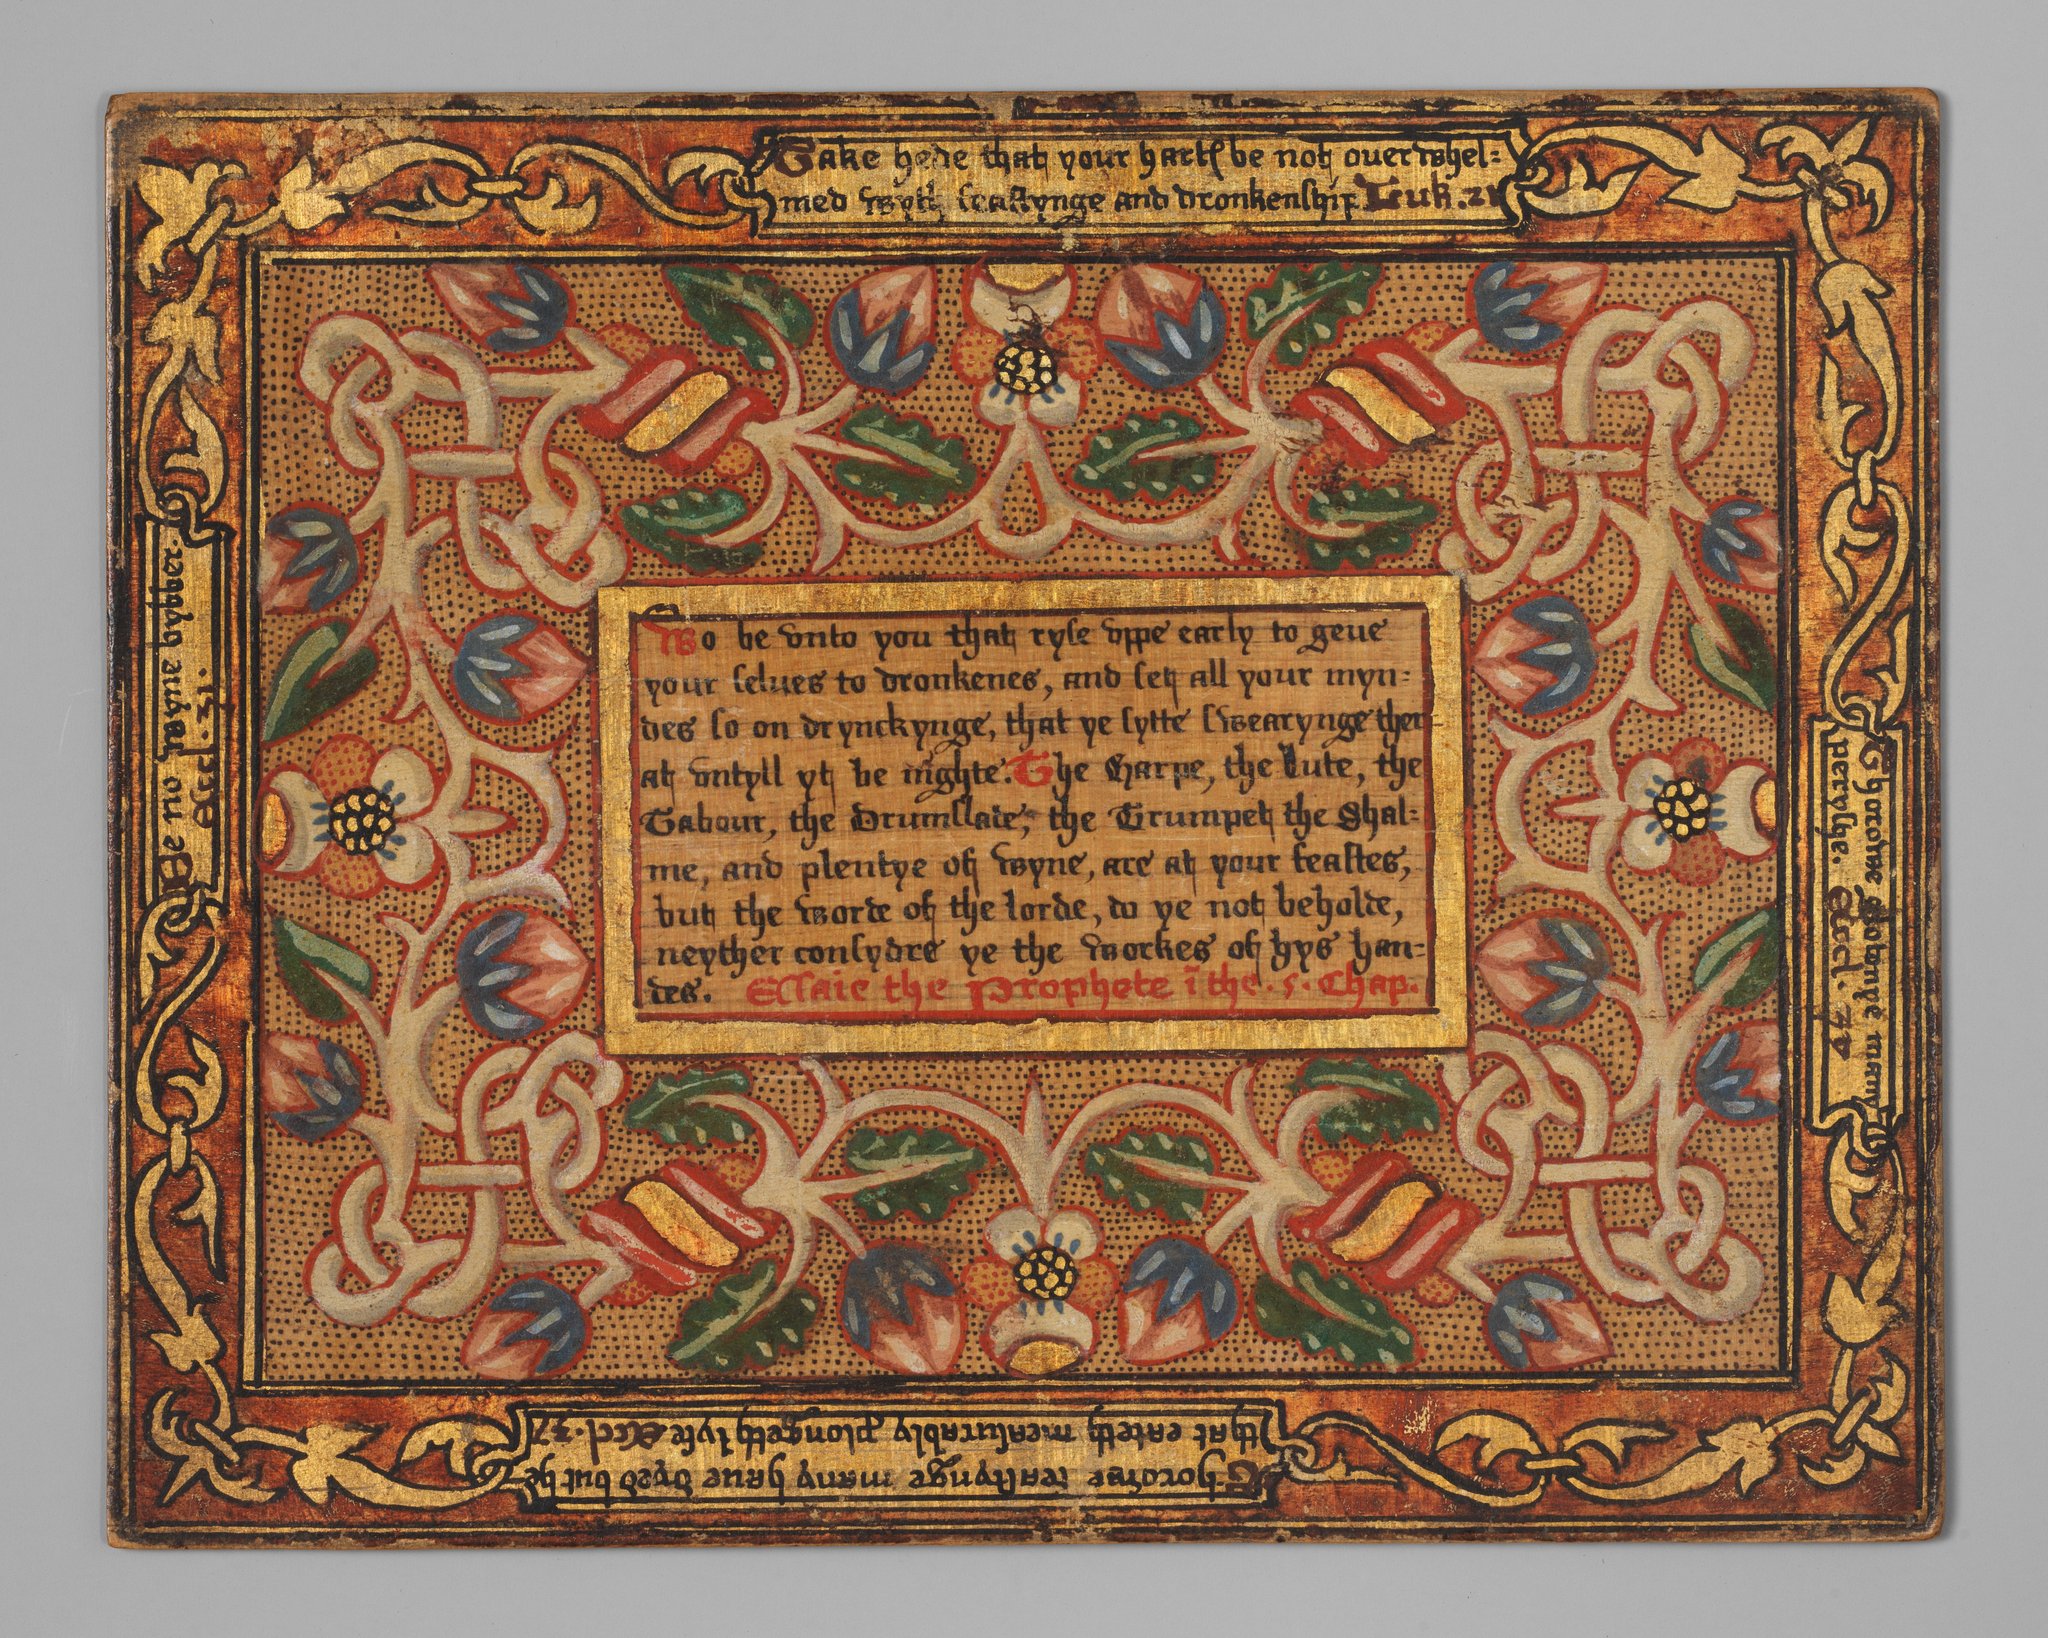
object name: trencher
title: Trencher with quotation from The Governance of Virtue (1566) (one of a set)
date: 1601-1633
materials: wood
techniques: gilding, painting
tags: flowers